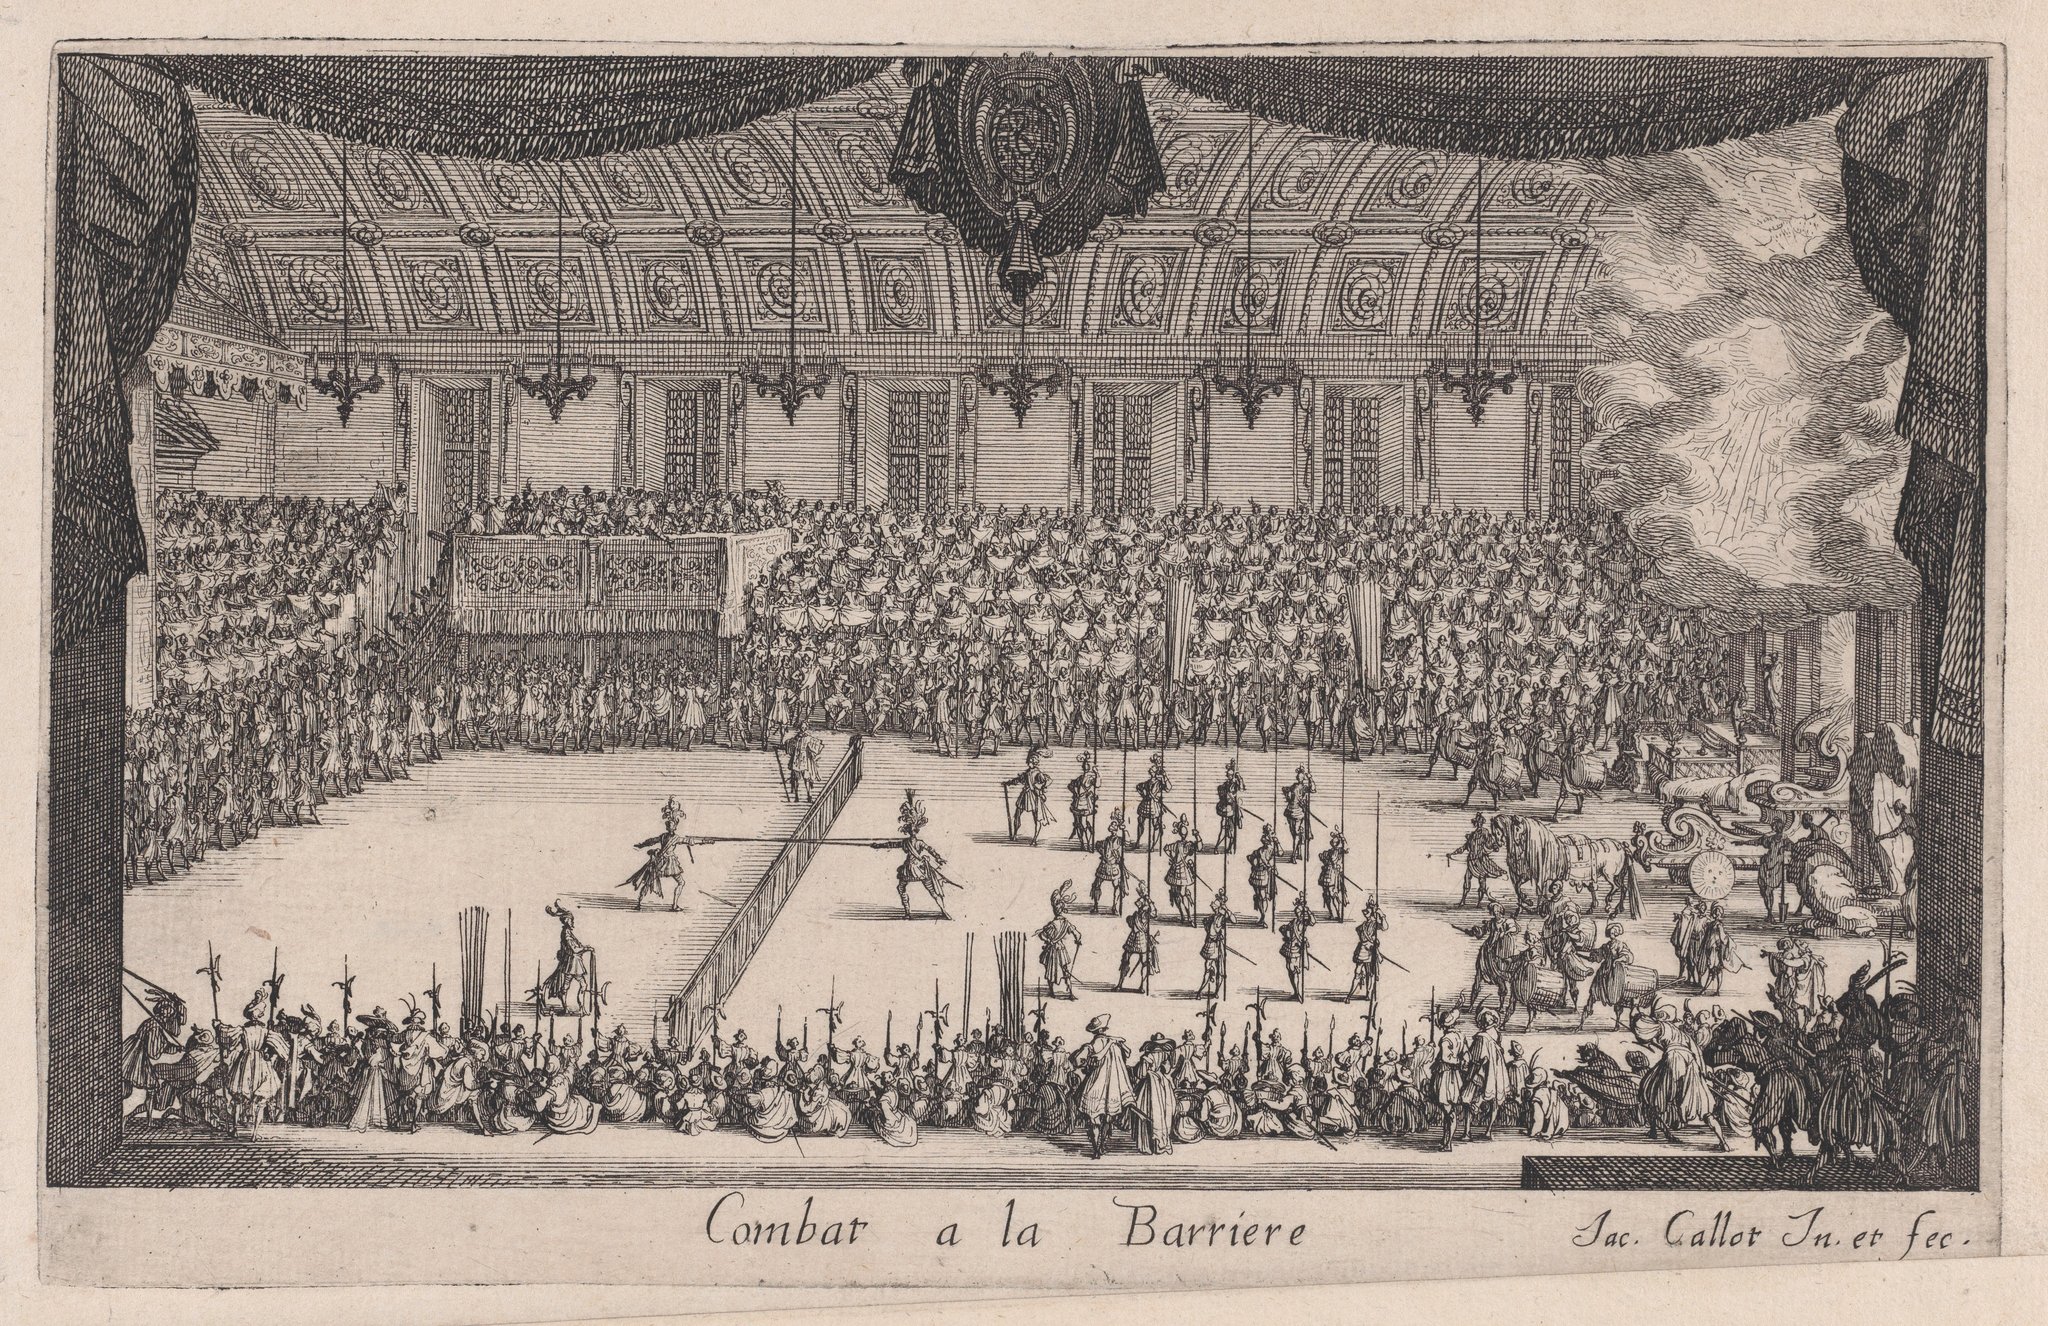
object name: print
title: Le Combat (The Combat), from Le Combat a la Barrière in the Palace at Nancy by Henri Humbert, printed by Sebastien Phillipe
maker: jacques callot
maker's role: artist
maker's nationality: french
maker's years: 1592-1635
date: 1627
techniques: etching